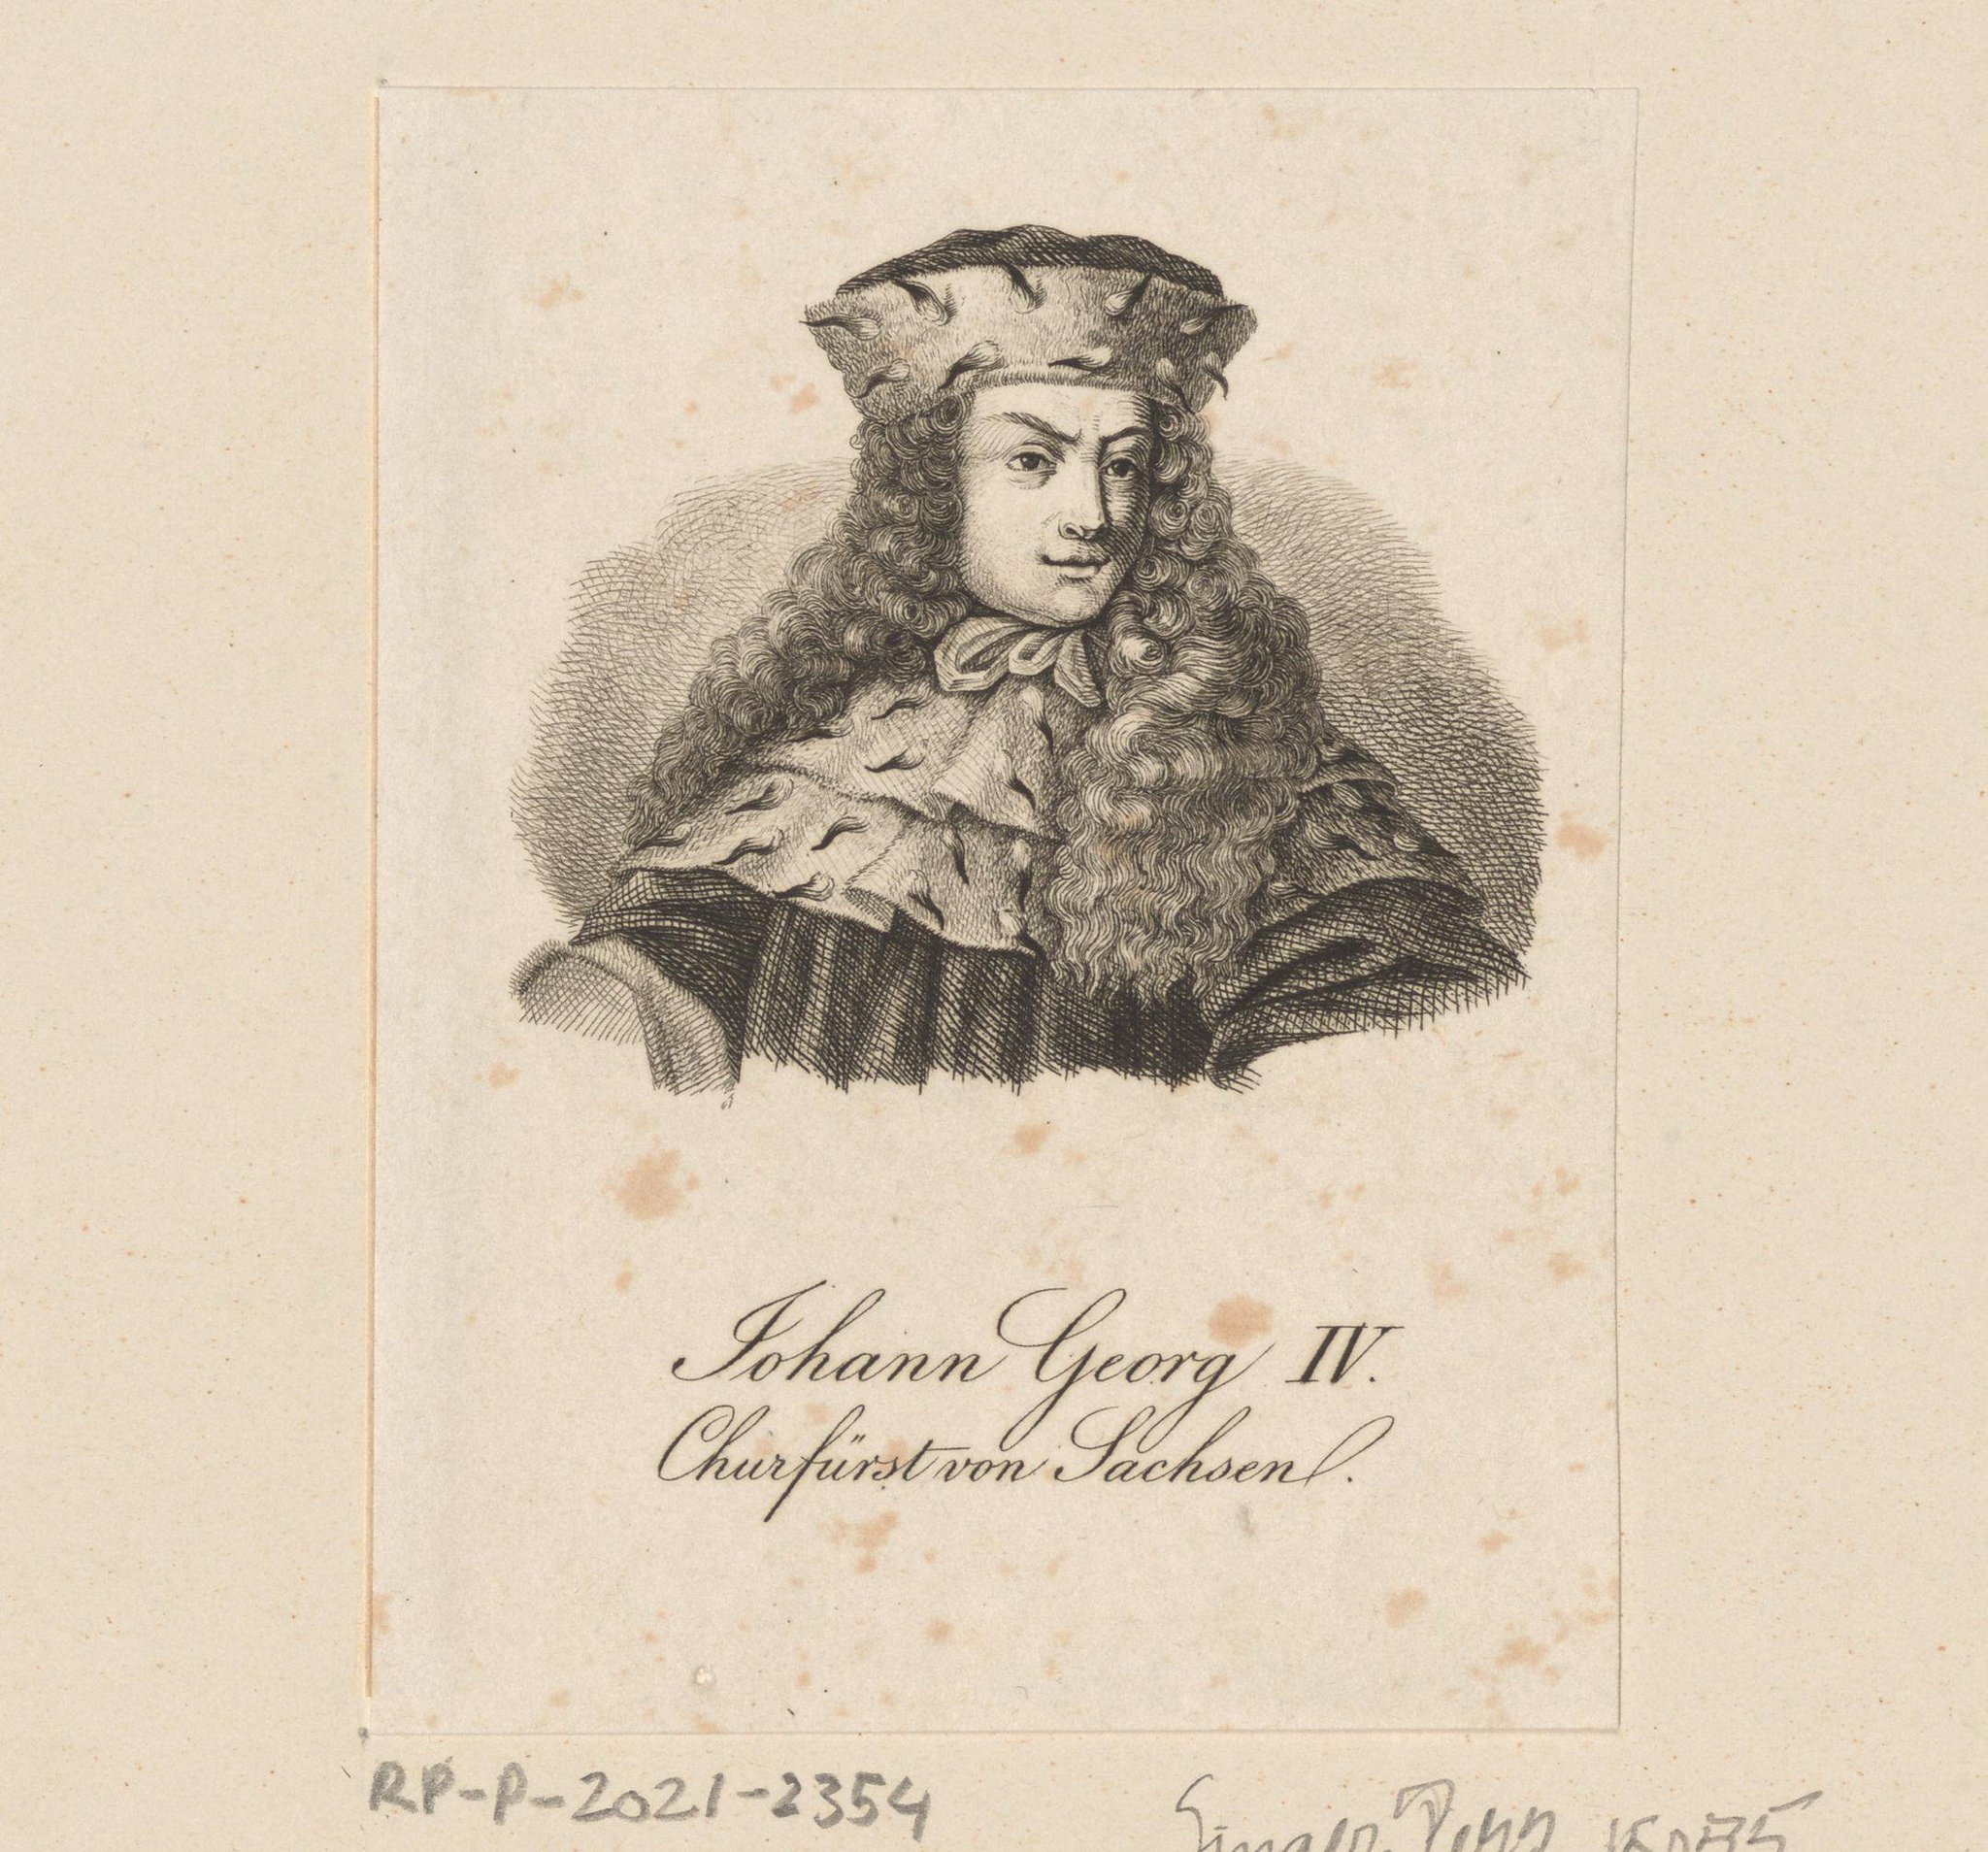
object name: print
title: Portret van Johan Georg III, keurvorst van Saksen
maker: Anonymous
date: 1800-1849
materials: paper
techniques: engraving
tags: historical persons, head-gear: hat, ruler, sovereign